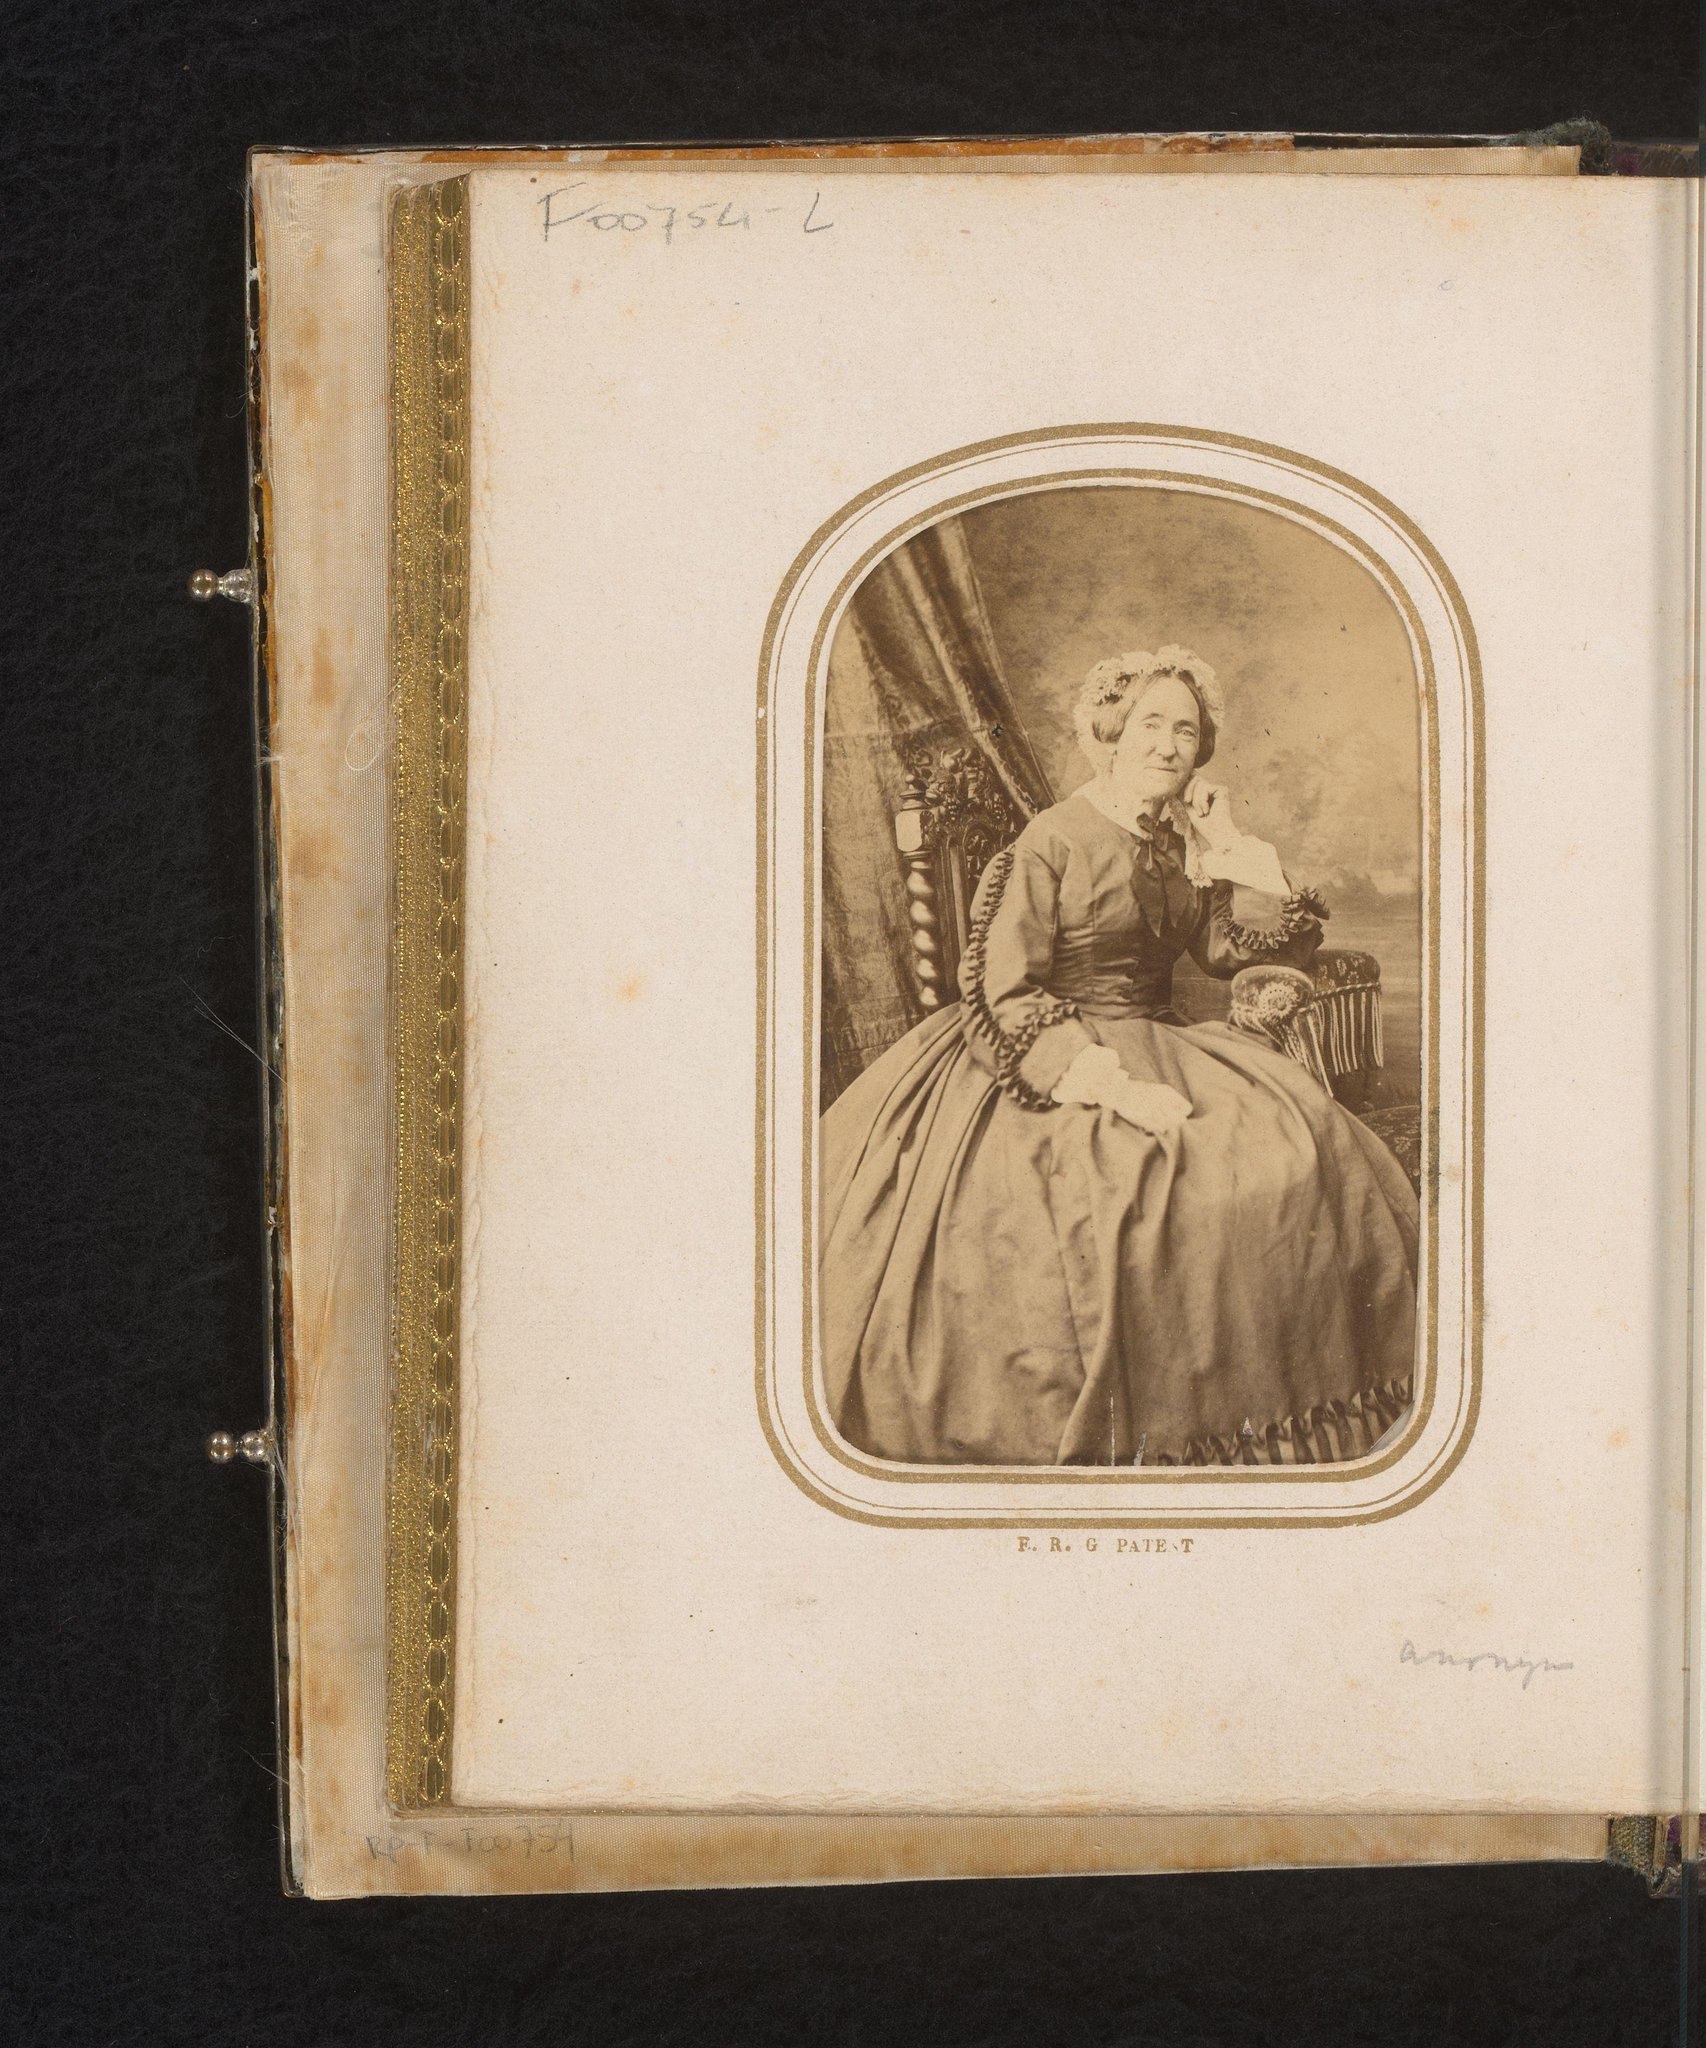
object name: carte de visite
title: Portret van een zittende oude vrouw met muts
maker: jules espagnet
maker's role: fotograaf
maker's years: 1819-1877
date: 1855-1880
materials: cardboard, photographic support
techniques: albumen print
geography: france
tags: historical persons - bb - woman, head-gear: cap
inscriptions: inscription: ‘[Espagnet]’